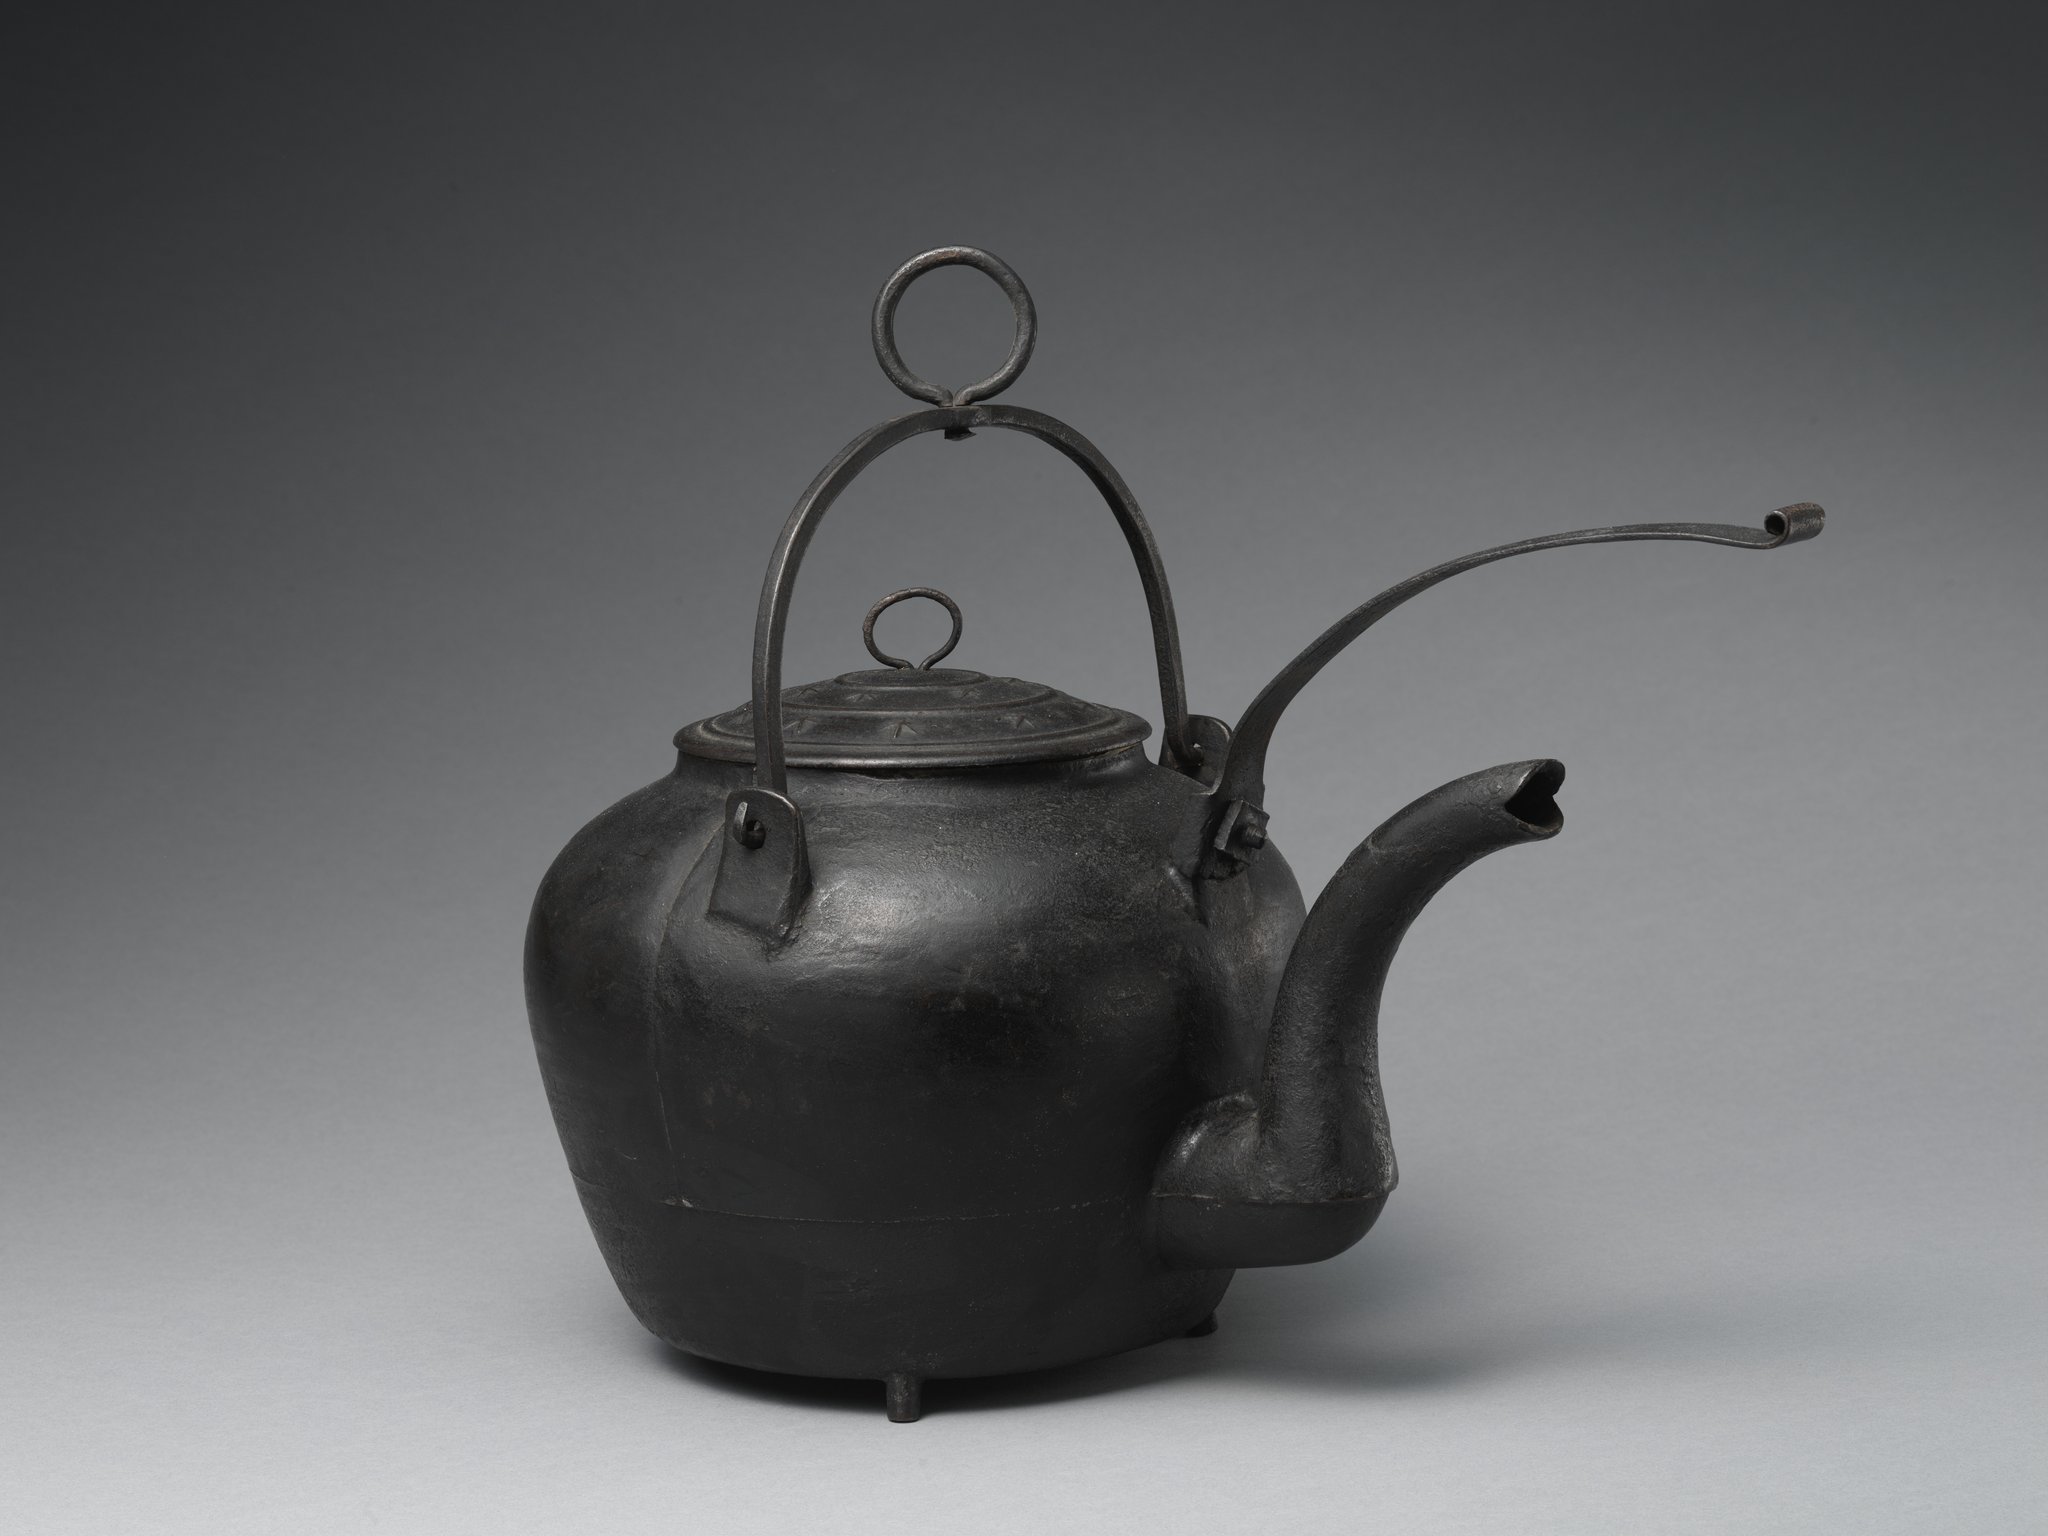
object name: kettle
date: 1700-1900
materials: iron